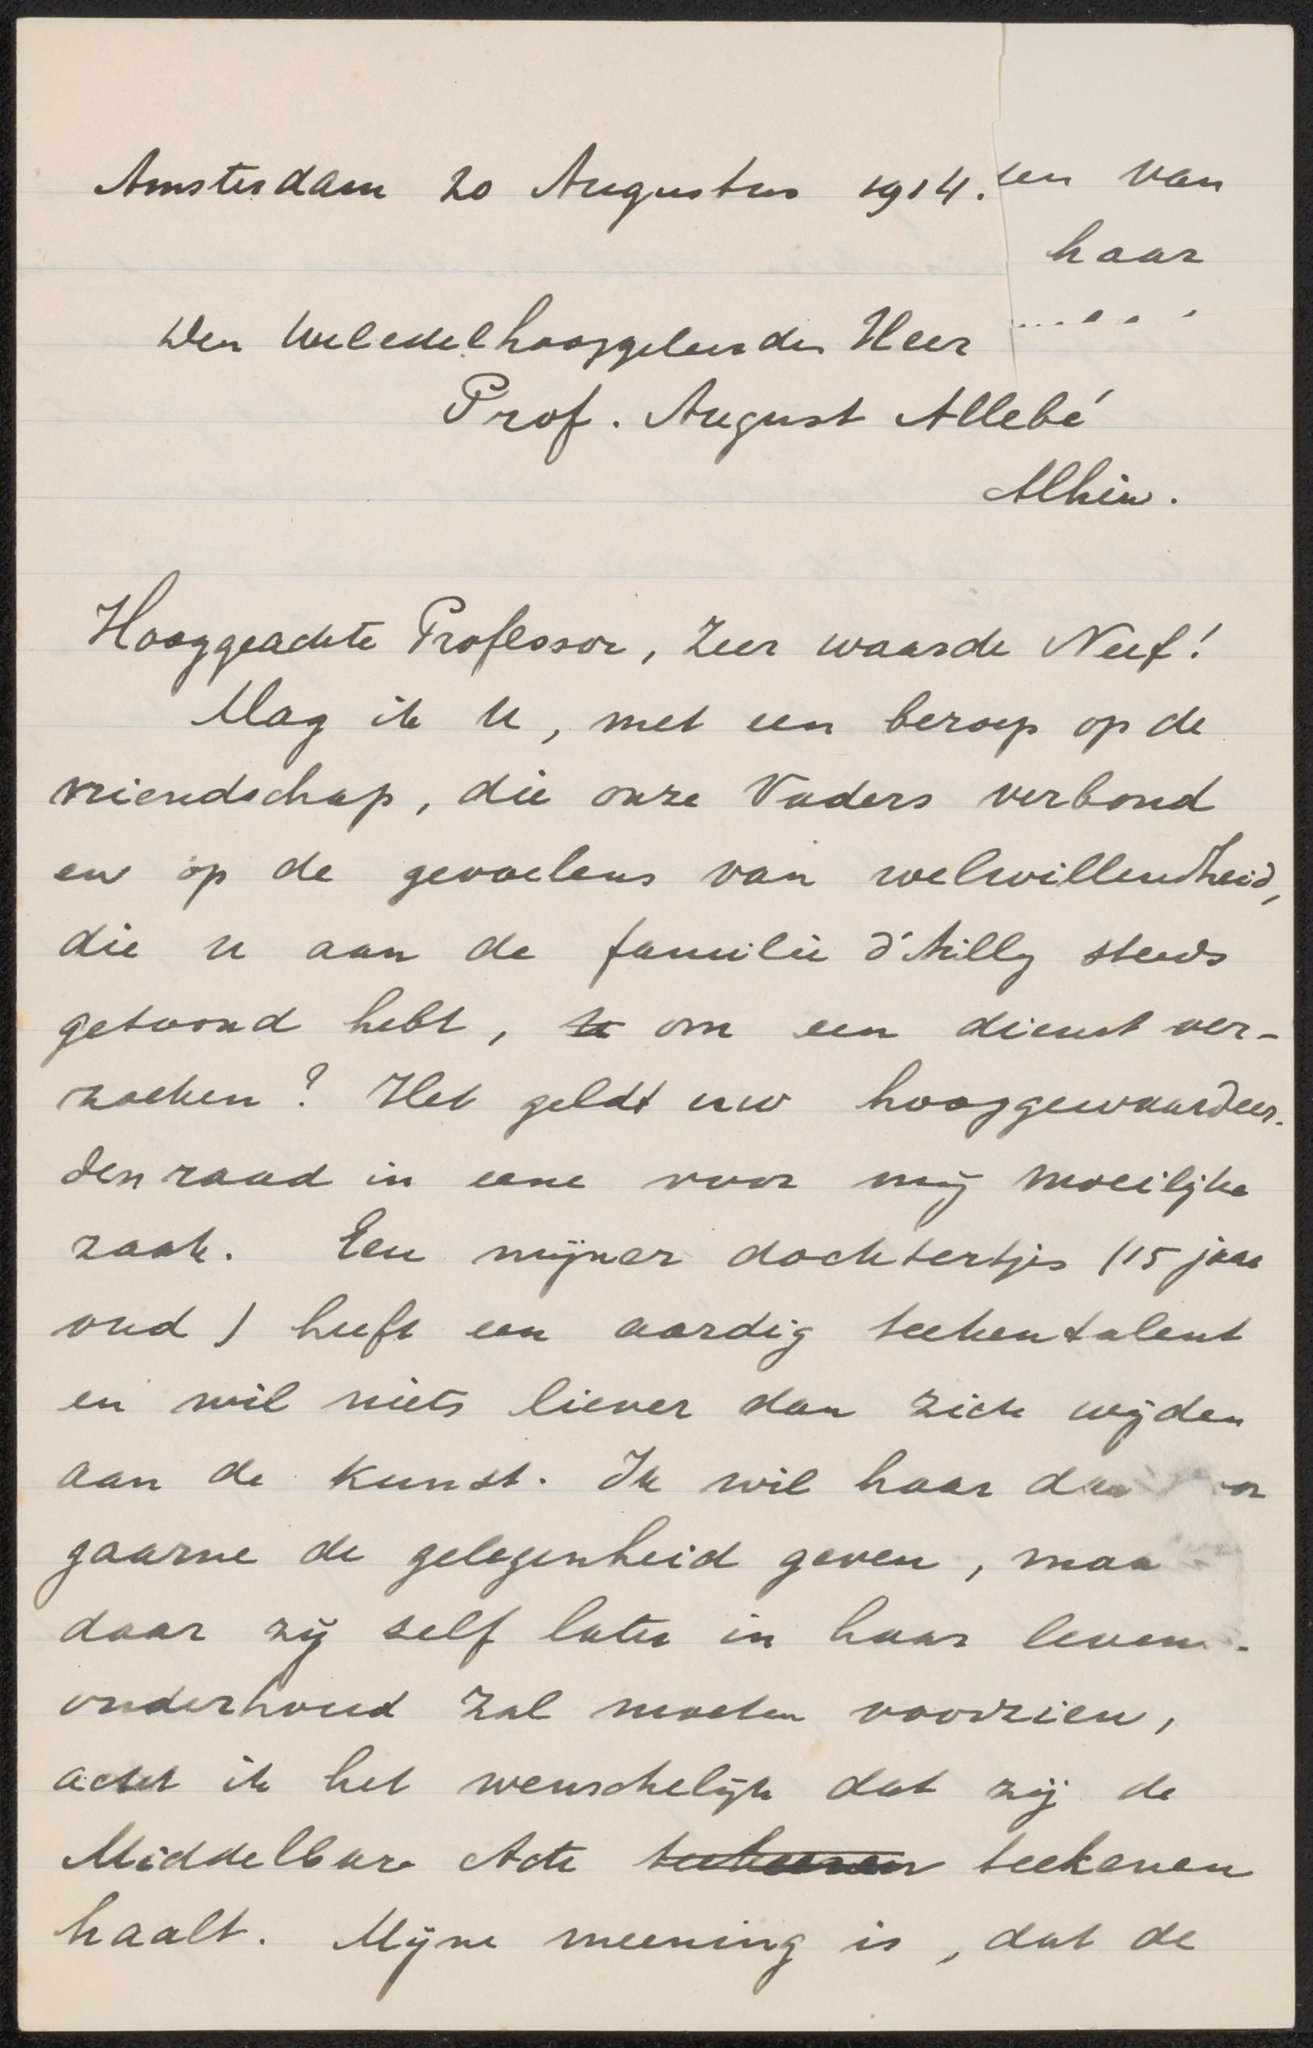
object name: letter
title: Brief aan August Allebé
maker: a.j. d ailly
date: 1914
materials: ink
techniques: pen, writing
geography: amsterdam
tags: amsterdam, august allebé, drawing, family life, education, tuition of the artist (in general)